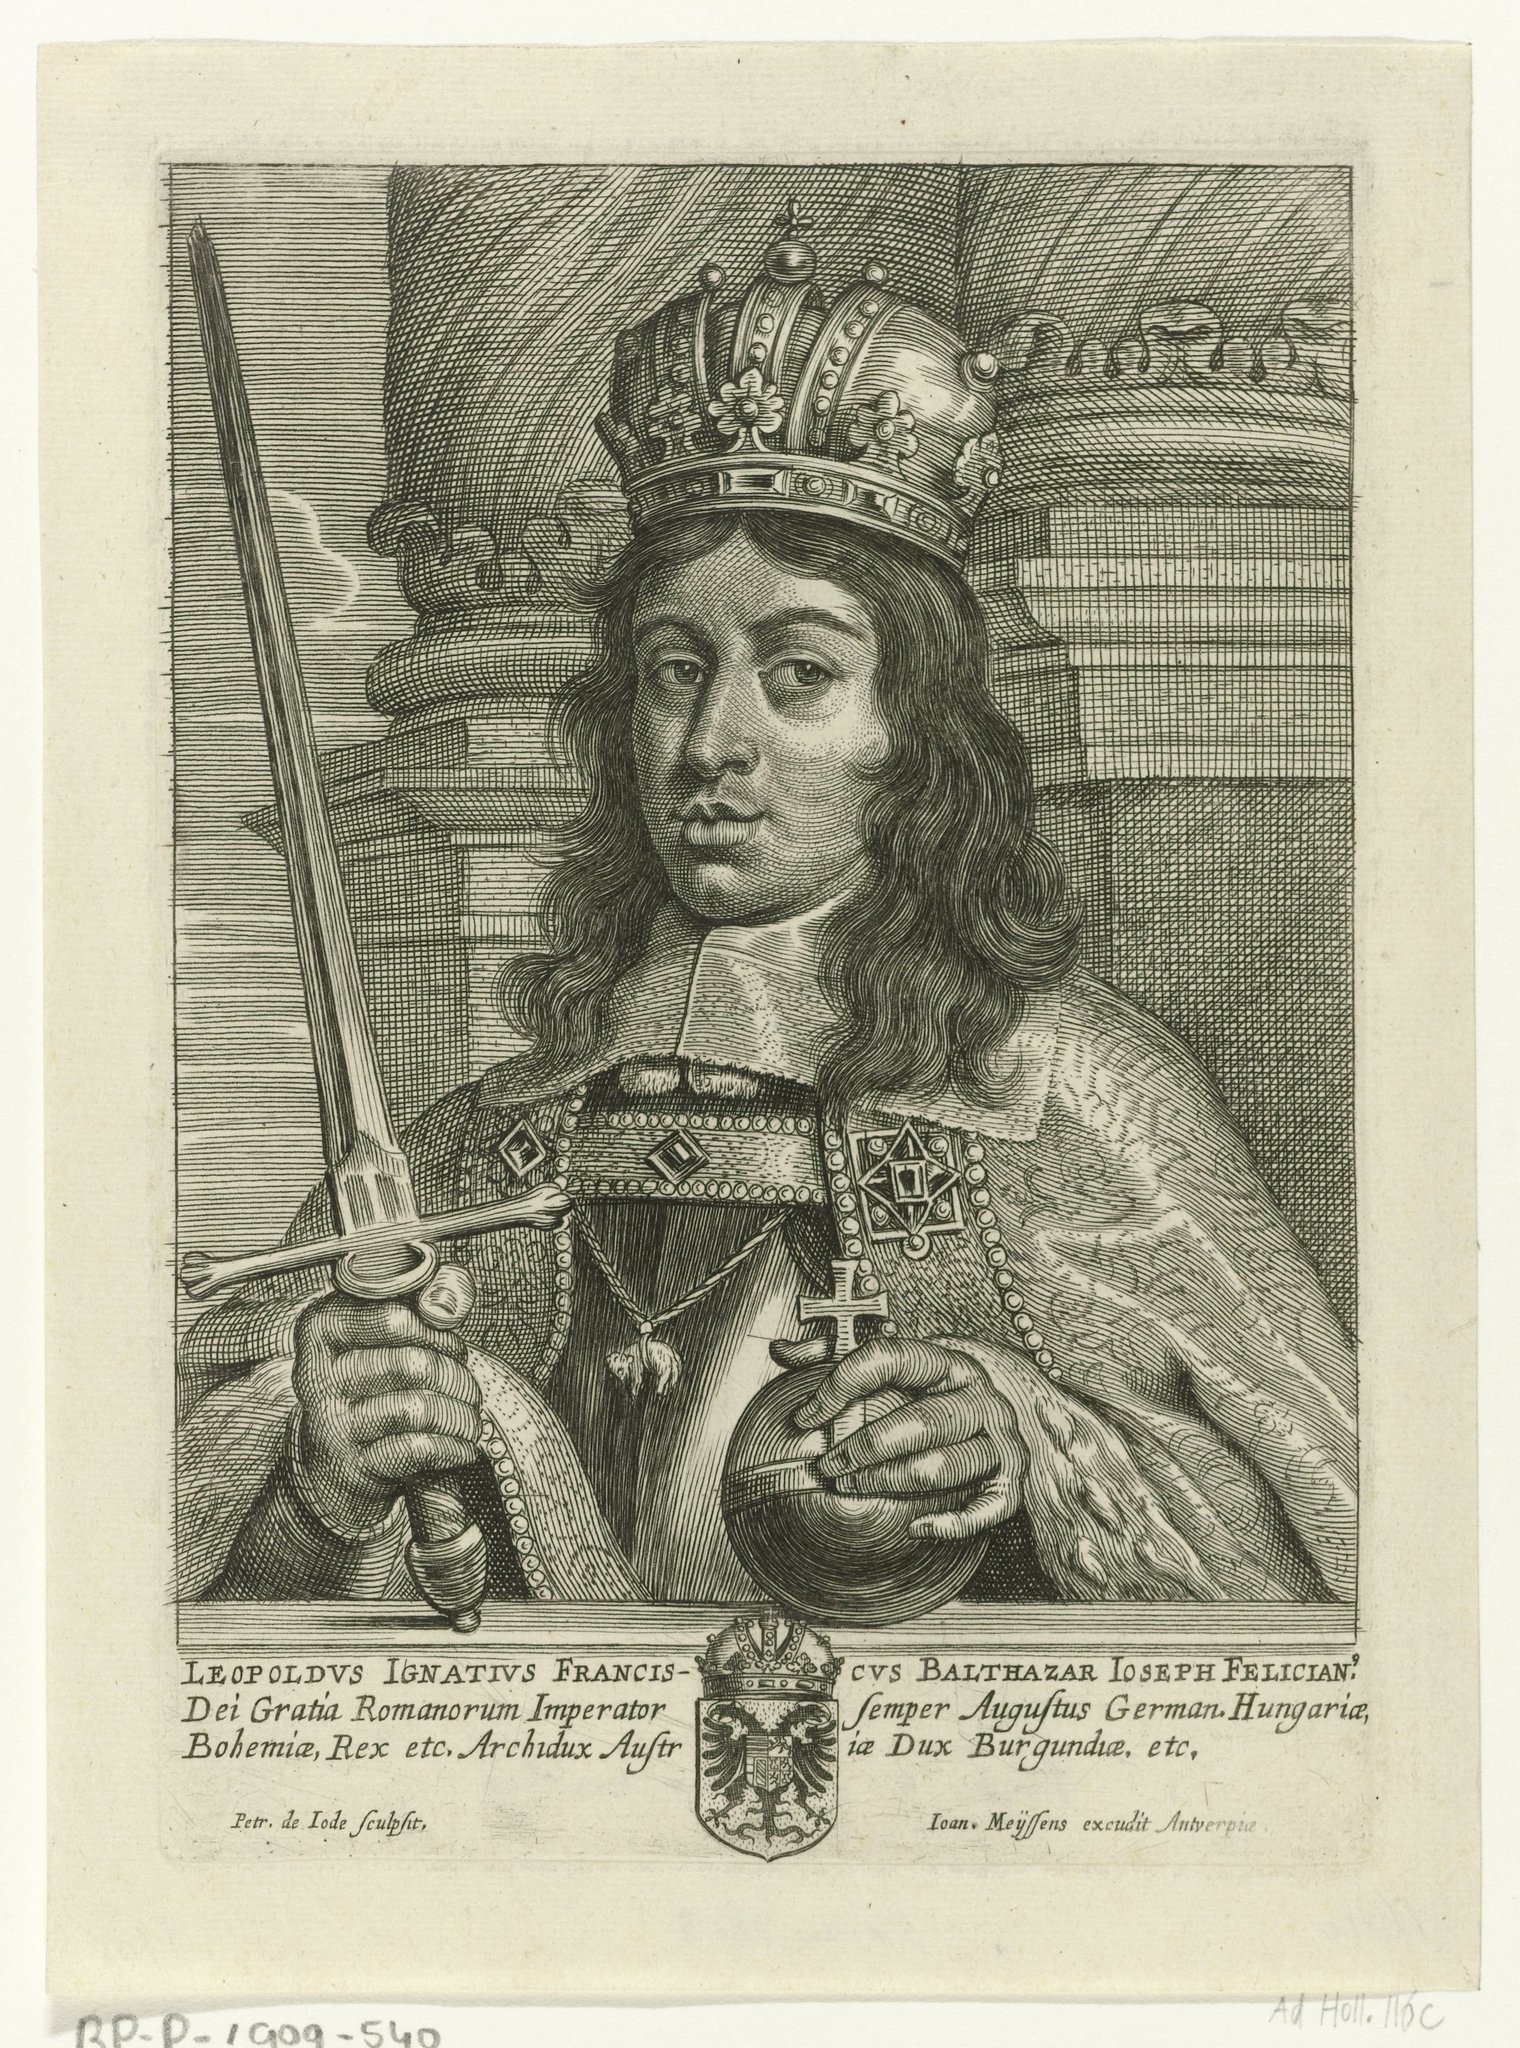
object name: print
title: Portret van keizer Leopold I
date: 1628-1670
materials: paper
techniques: engraving, etching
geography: antwerp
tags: vienna, leopold i (keizer van duitsland), hacking and thrusting weapons: sword, knighthood order of the golden fleece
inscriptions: collector's mark: Lugt 2228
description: Portret van Leopold I, keizer van Duitsland. Hij staat aan de voet van twee zuilen. Hij is gekroond en draagt een keten met de Orde van het Gulden Vlies. In zijn rechterhand houdt hij een zwaard en zijn linkerhand rust op een rijksappel. In de marge het wapenschild van de geportretteerde en een drieregelig onderschrift in het Latijn.